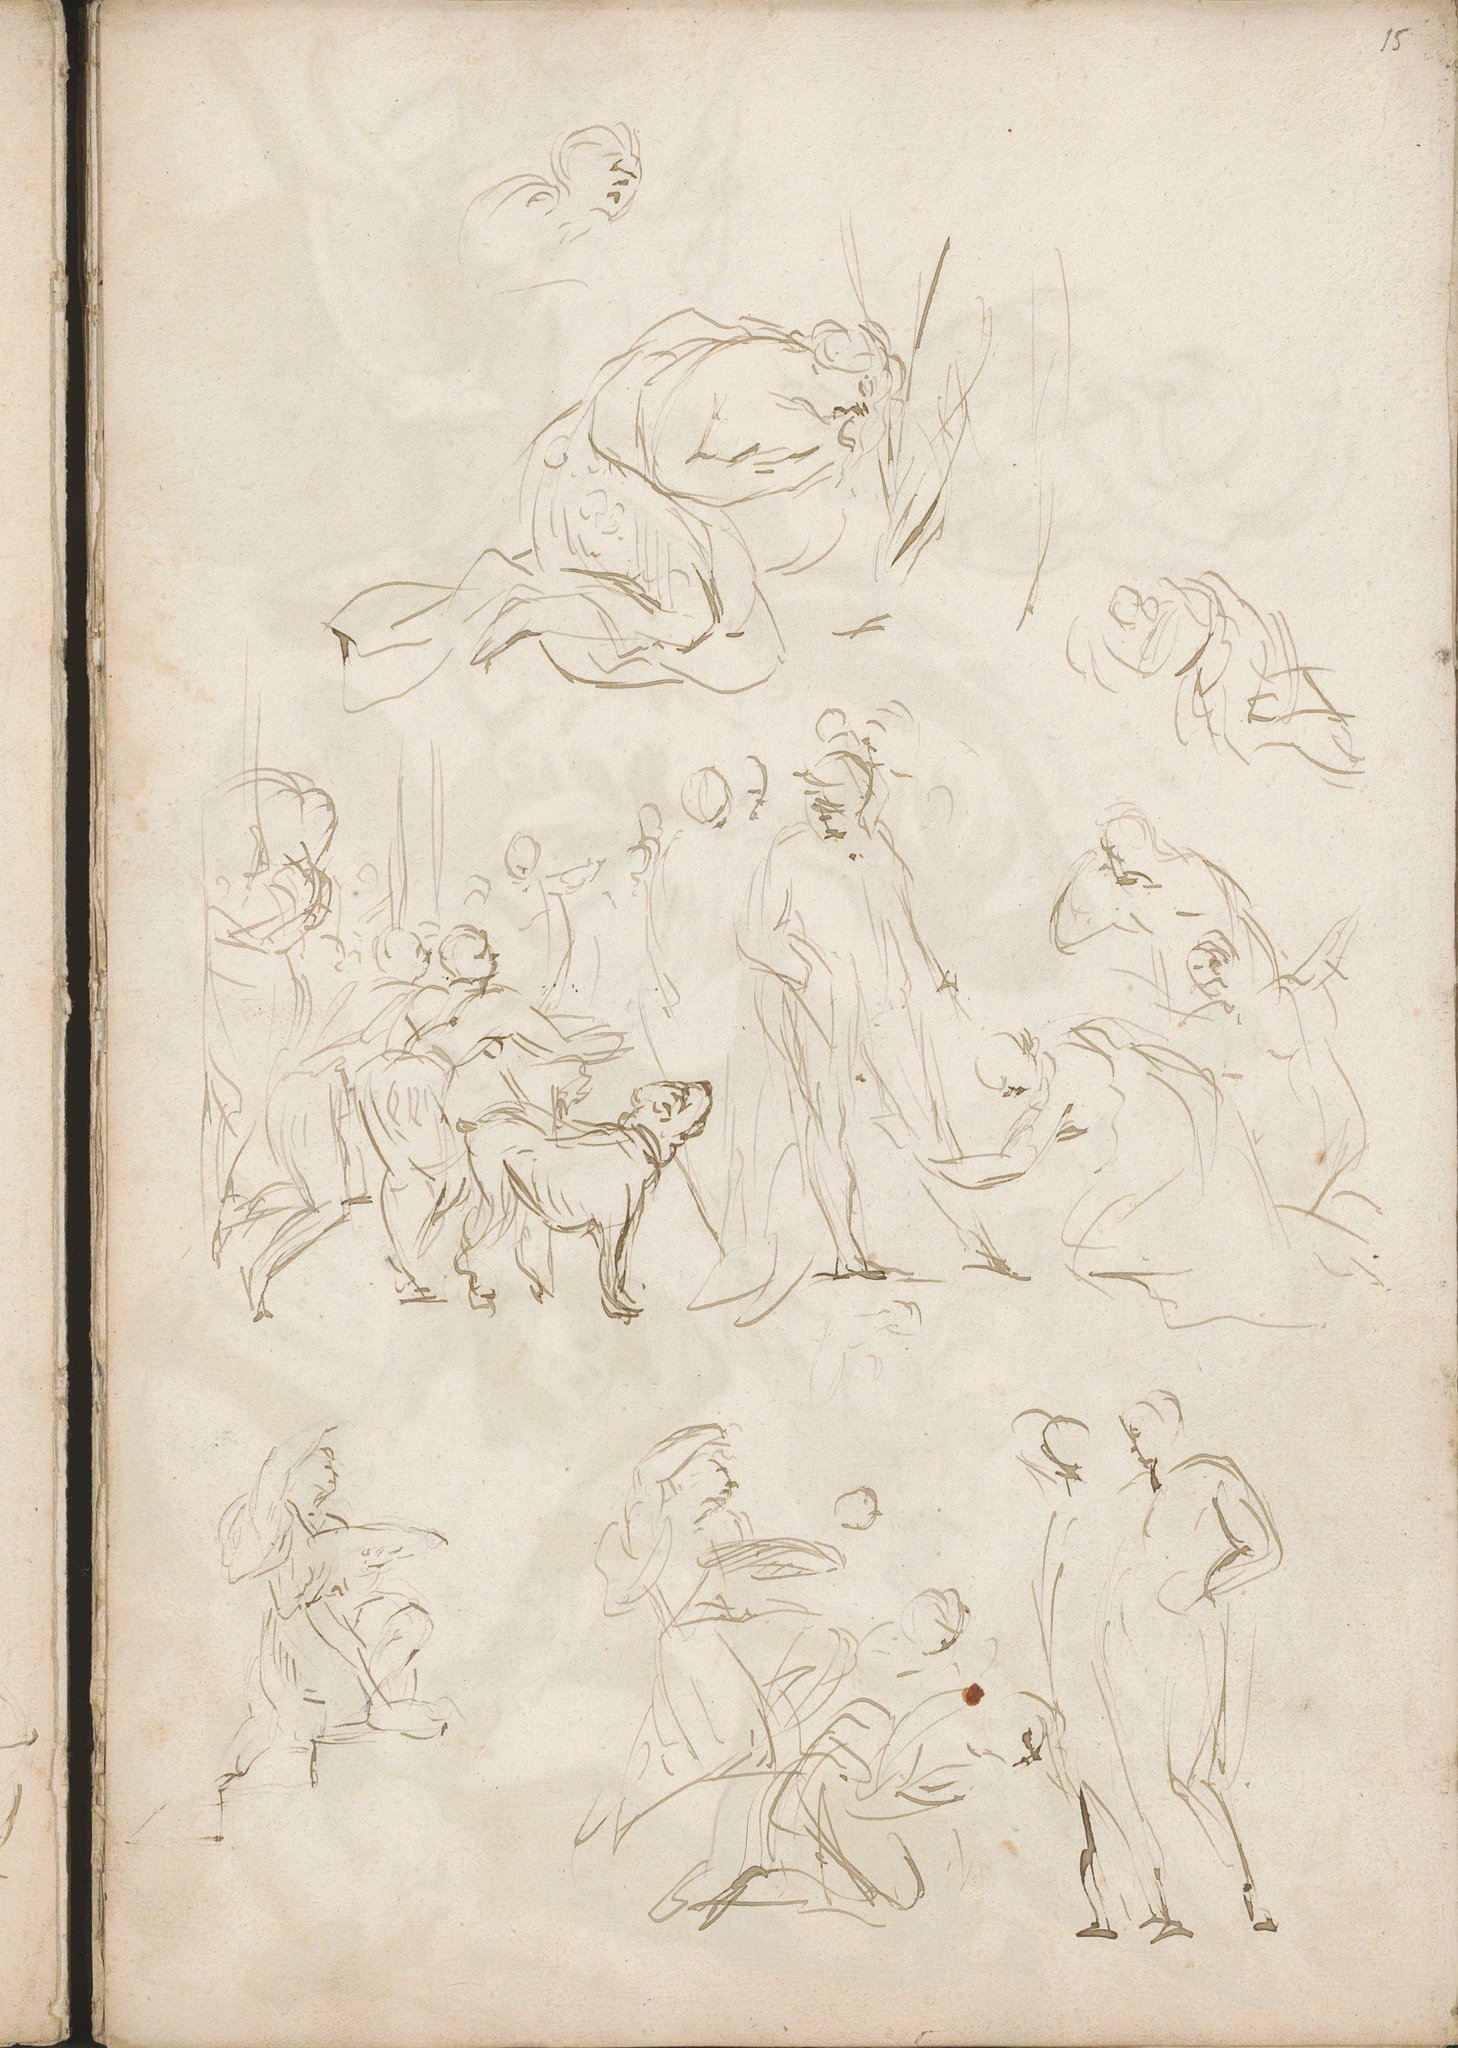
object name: sketchbook leaf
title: Groep figuren buigend en knielend voor een man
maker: Anonymous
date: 1650-1799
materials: ink, paper, pencil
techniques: pen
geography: italy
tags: bending figure, kneeling figure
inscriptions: annotation: ‘il ve alimenta la pittúra/ g/zij? broed/ de schilder kunst’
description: Tevens studies van voorovergebogen en weeklagende figuren. Bladzijde 15 uit een schetsboek met 72 bladzijden.